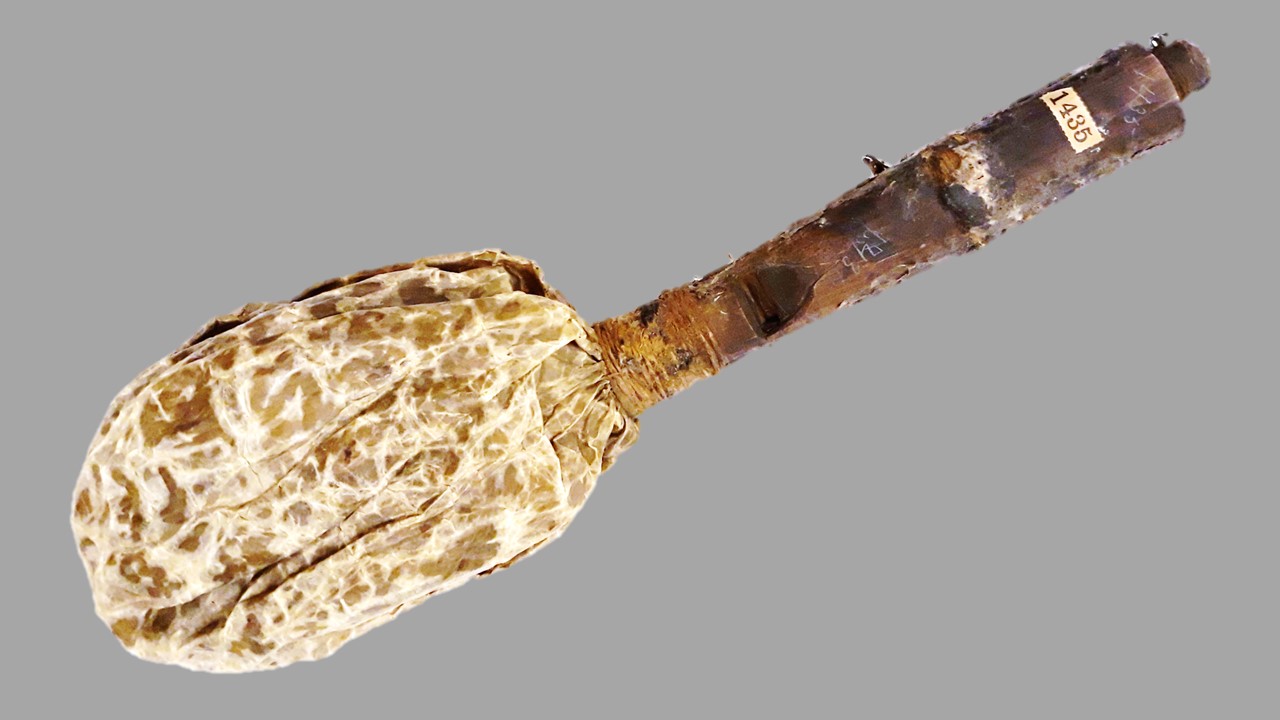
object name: stopped pipe mechanically blown whistle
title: Stopped pipe (mechanically blown whistle)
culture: native american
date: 1801-1833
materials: cord, wood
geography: canada